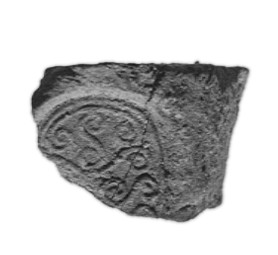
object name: sealing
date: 2030-1640 BCE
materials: clay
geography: egypt